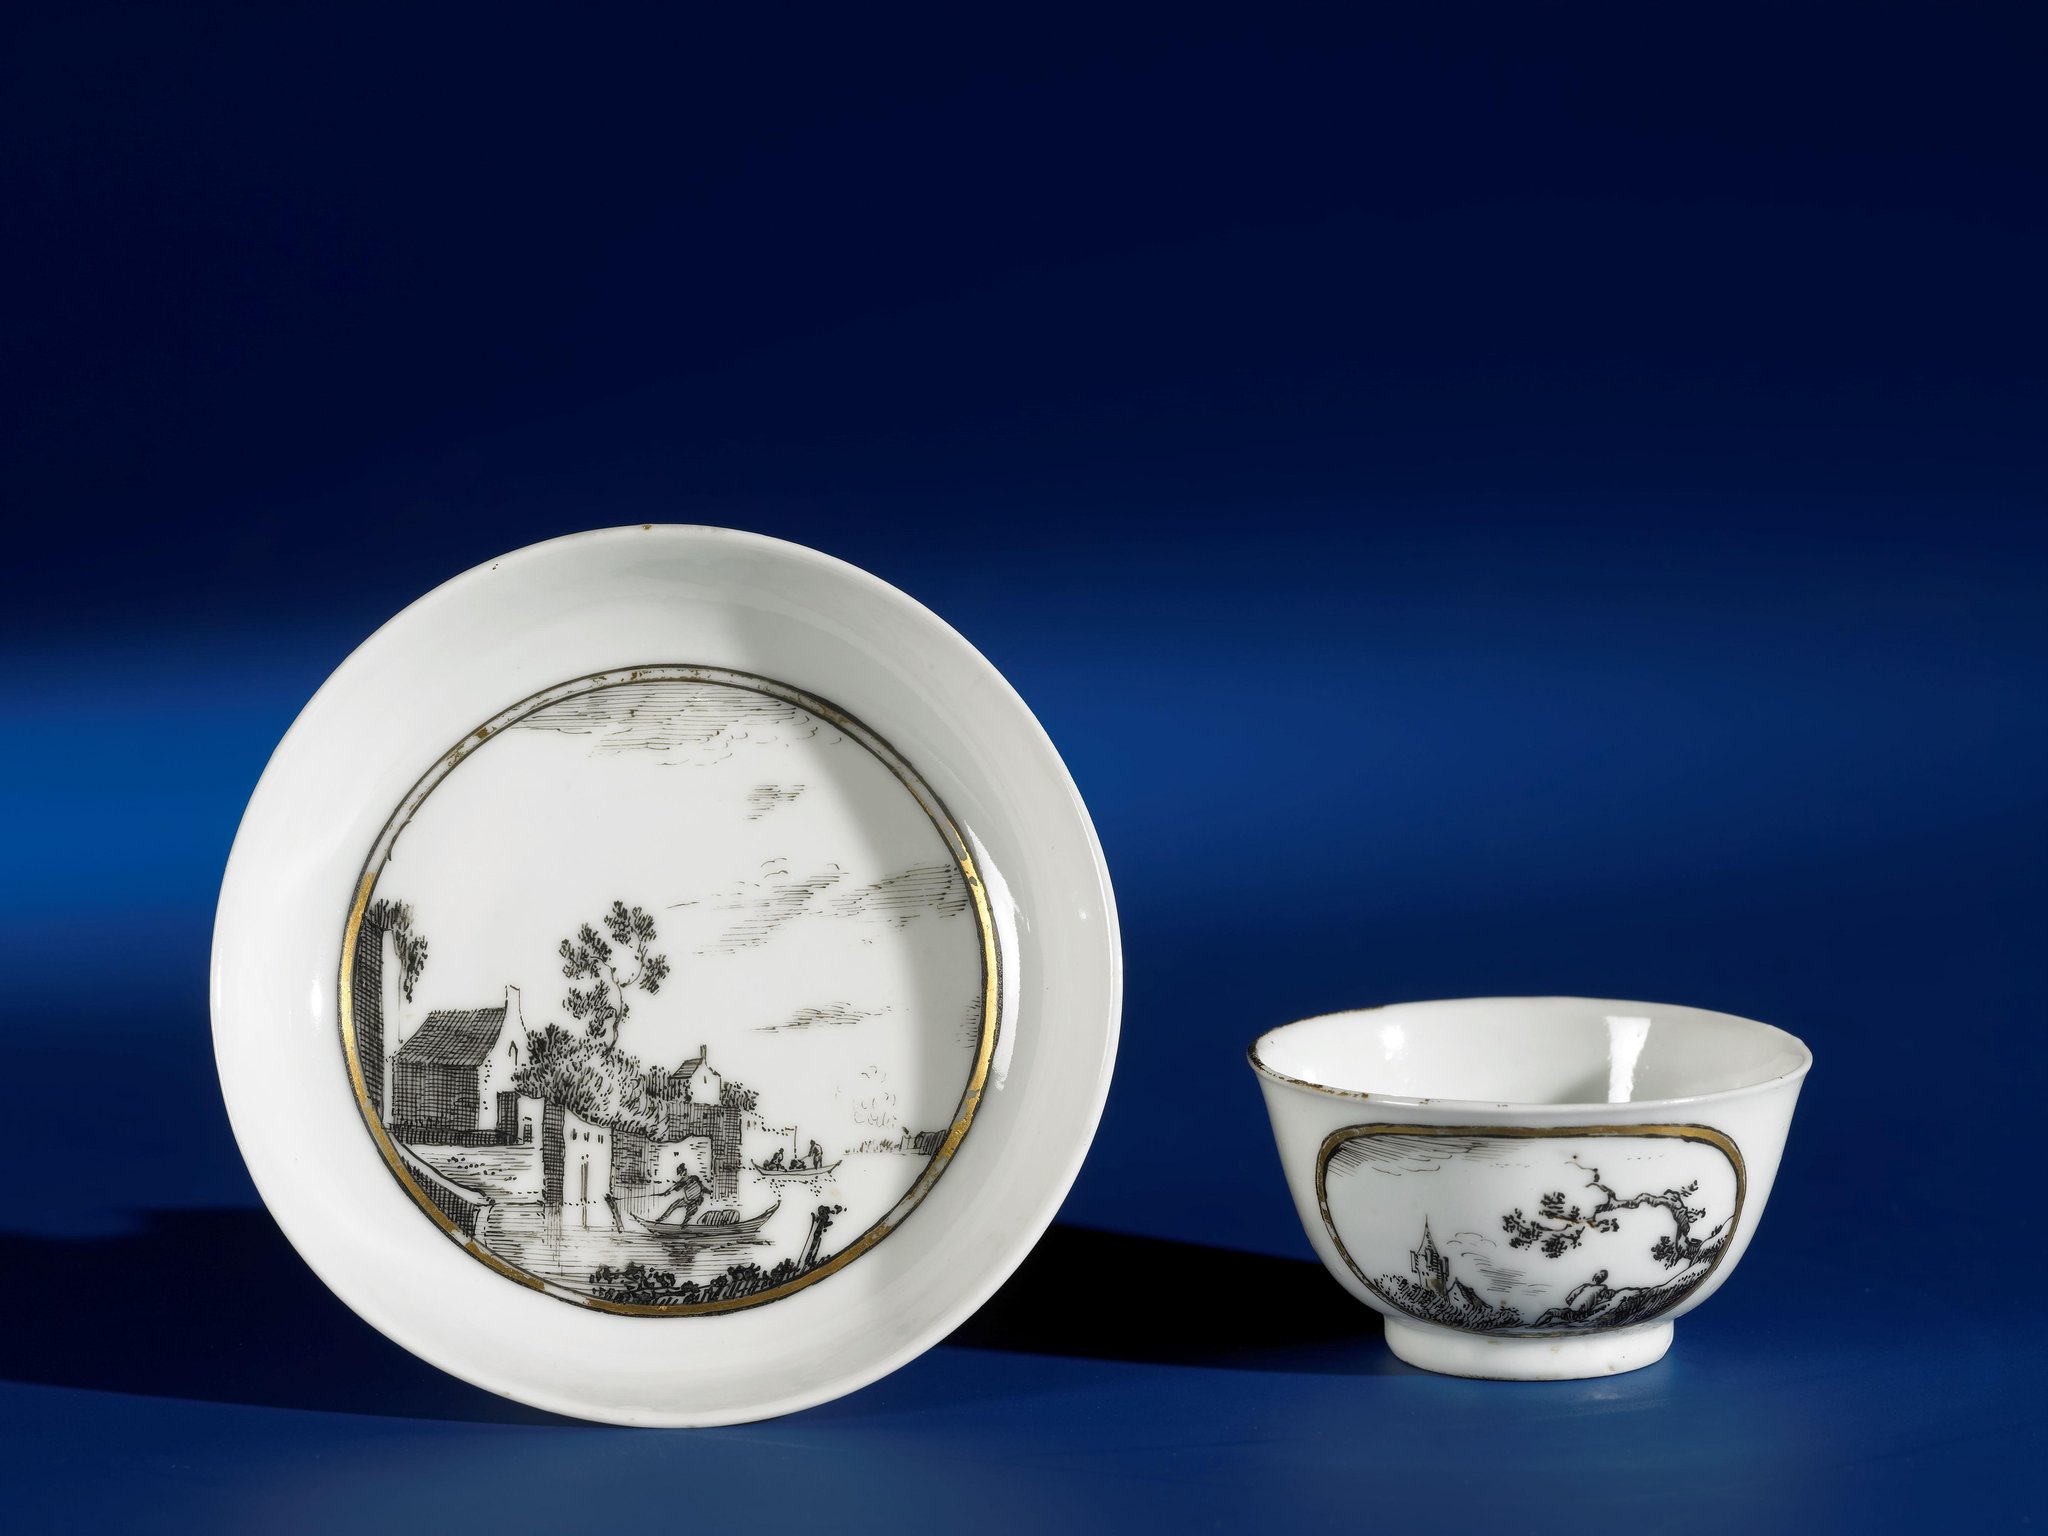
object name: platter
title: Saucer with European landschapes in medallions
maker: Anonymous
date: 1775-1799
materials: glaze, gold, paint, porcelain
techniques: firing, gilding, turning, vitrification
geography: china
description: Kop en schotel op een voetring, de kop met een enigszins uitlopende wand. Gedecoreerd in encre de Chine en goud met Hollandse landschappen. Op de schotel een rivierlandschap met huizen aan de oever en twee kleine boten op de rivier; op de kop twee verschillende dorpsgezichten. De voorstellingen zijn steeds omgeven door een gouden band (rond opde schotel, ovaal op de kop). Mogelijk in Nederland beschilderd.